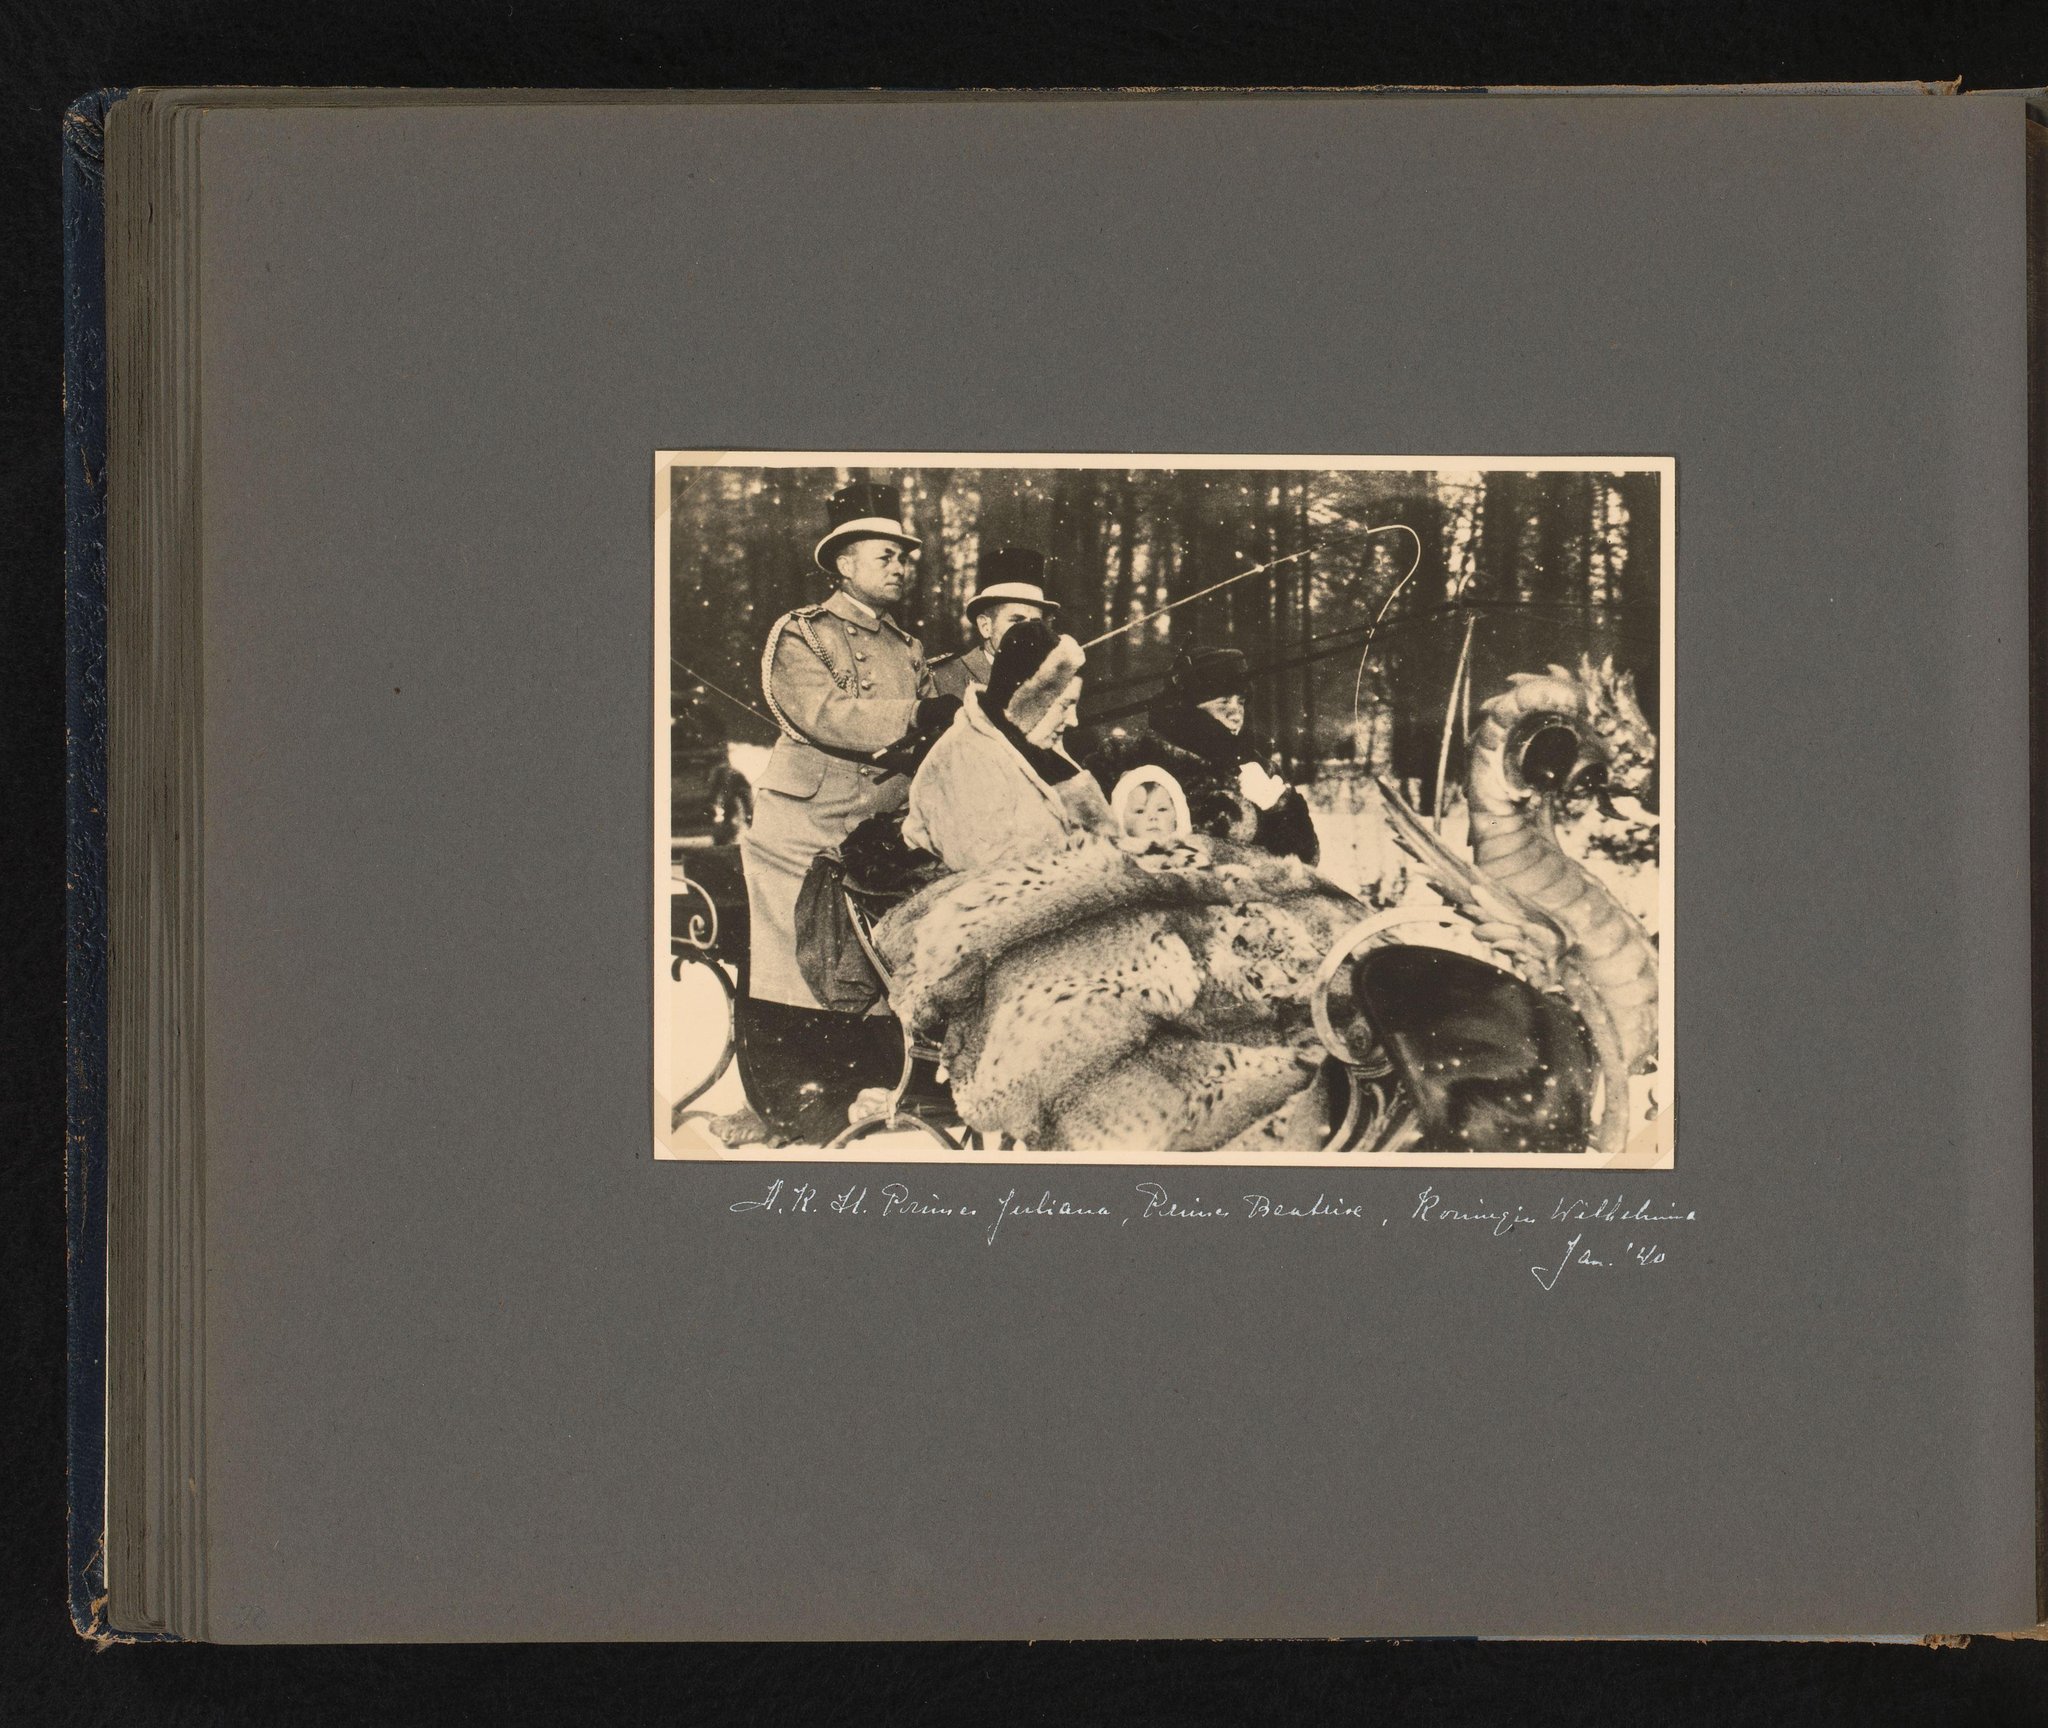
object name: photograph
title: Koninklijke familie in de arrenslee, januari 1940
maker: gompers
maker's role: fotograaf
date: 1940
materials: cardboard, photographic support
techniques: gelatin silver print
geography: amsterdam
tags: the hague, print maker, wilhelmina of the netherlands, beatrix (koningin der nederlanden), juliana of the netherlands, parents with their children, horse-sleigh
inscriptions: number: ‘331’, date: ‘H.K.H. Prinses Juliana, Prinses Beatrix, Koningin Wilhelmina Jan. '40’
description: Albumblad met een foto van de Koninklijke Familie in een arrenslee in de sneeuw in het Haagse Bos, 24 januari 1940. Onderdeel van fotoalbum over het familieleven van de leden van het Koninklijk Huis tussen 1937-1945.